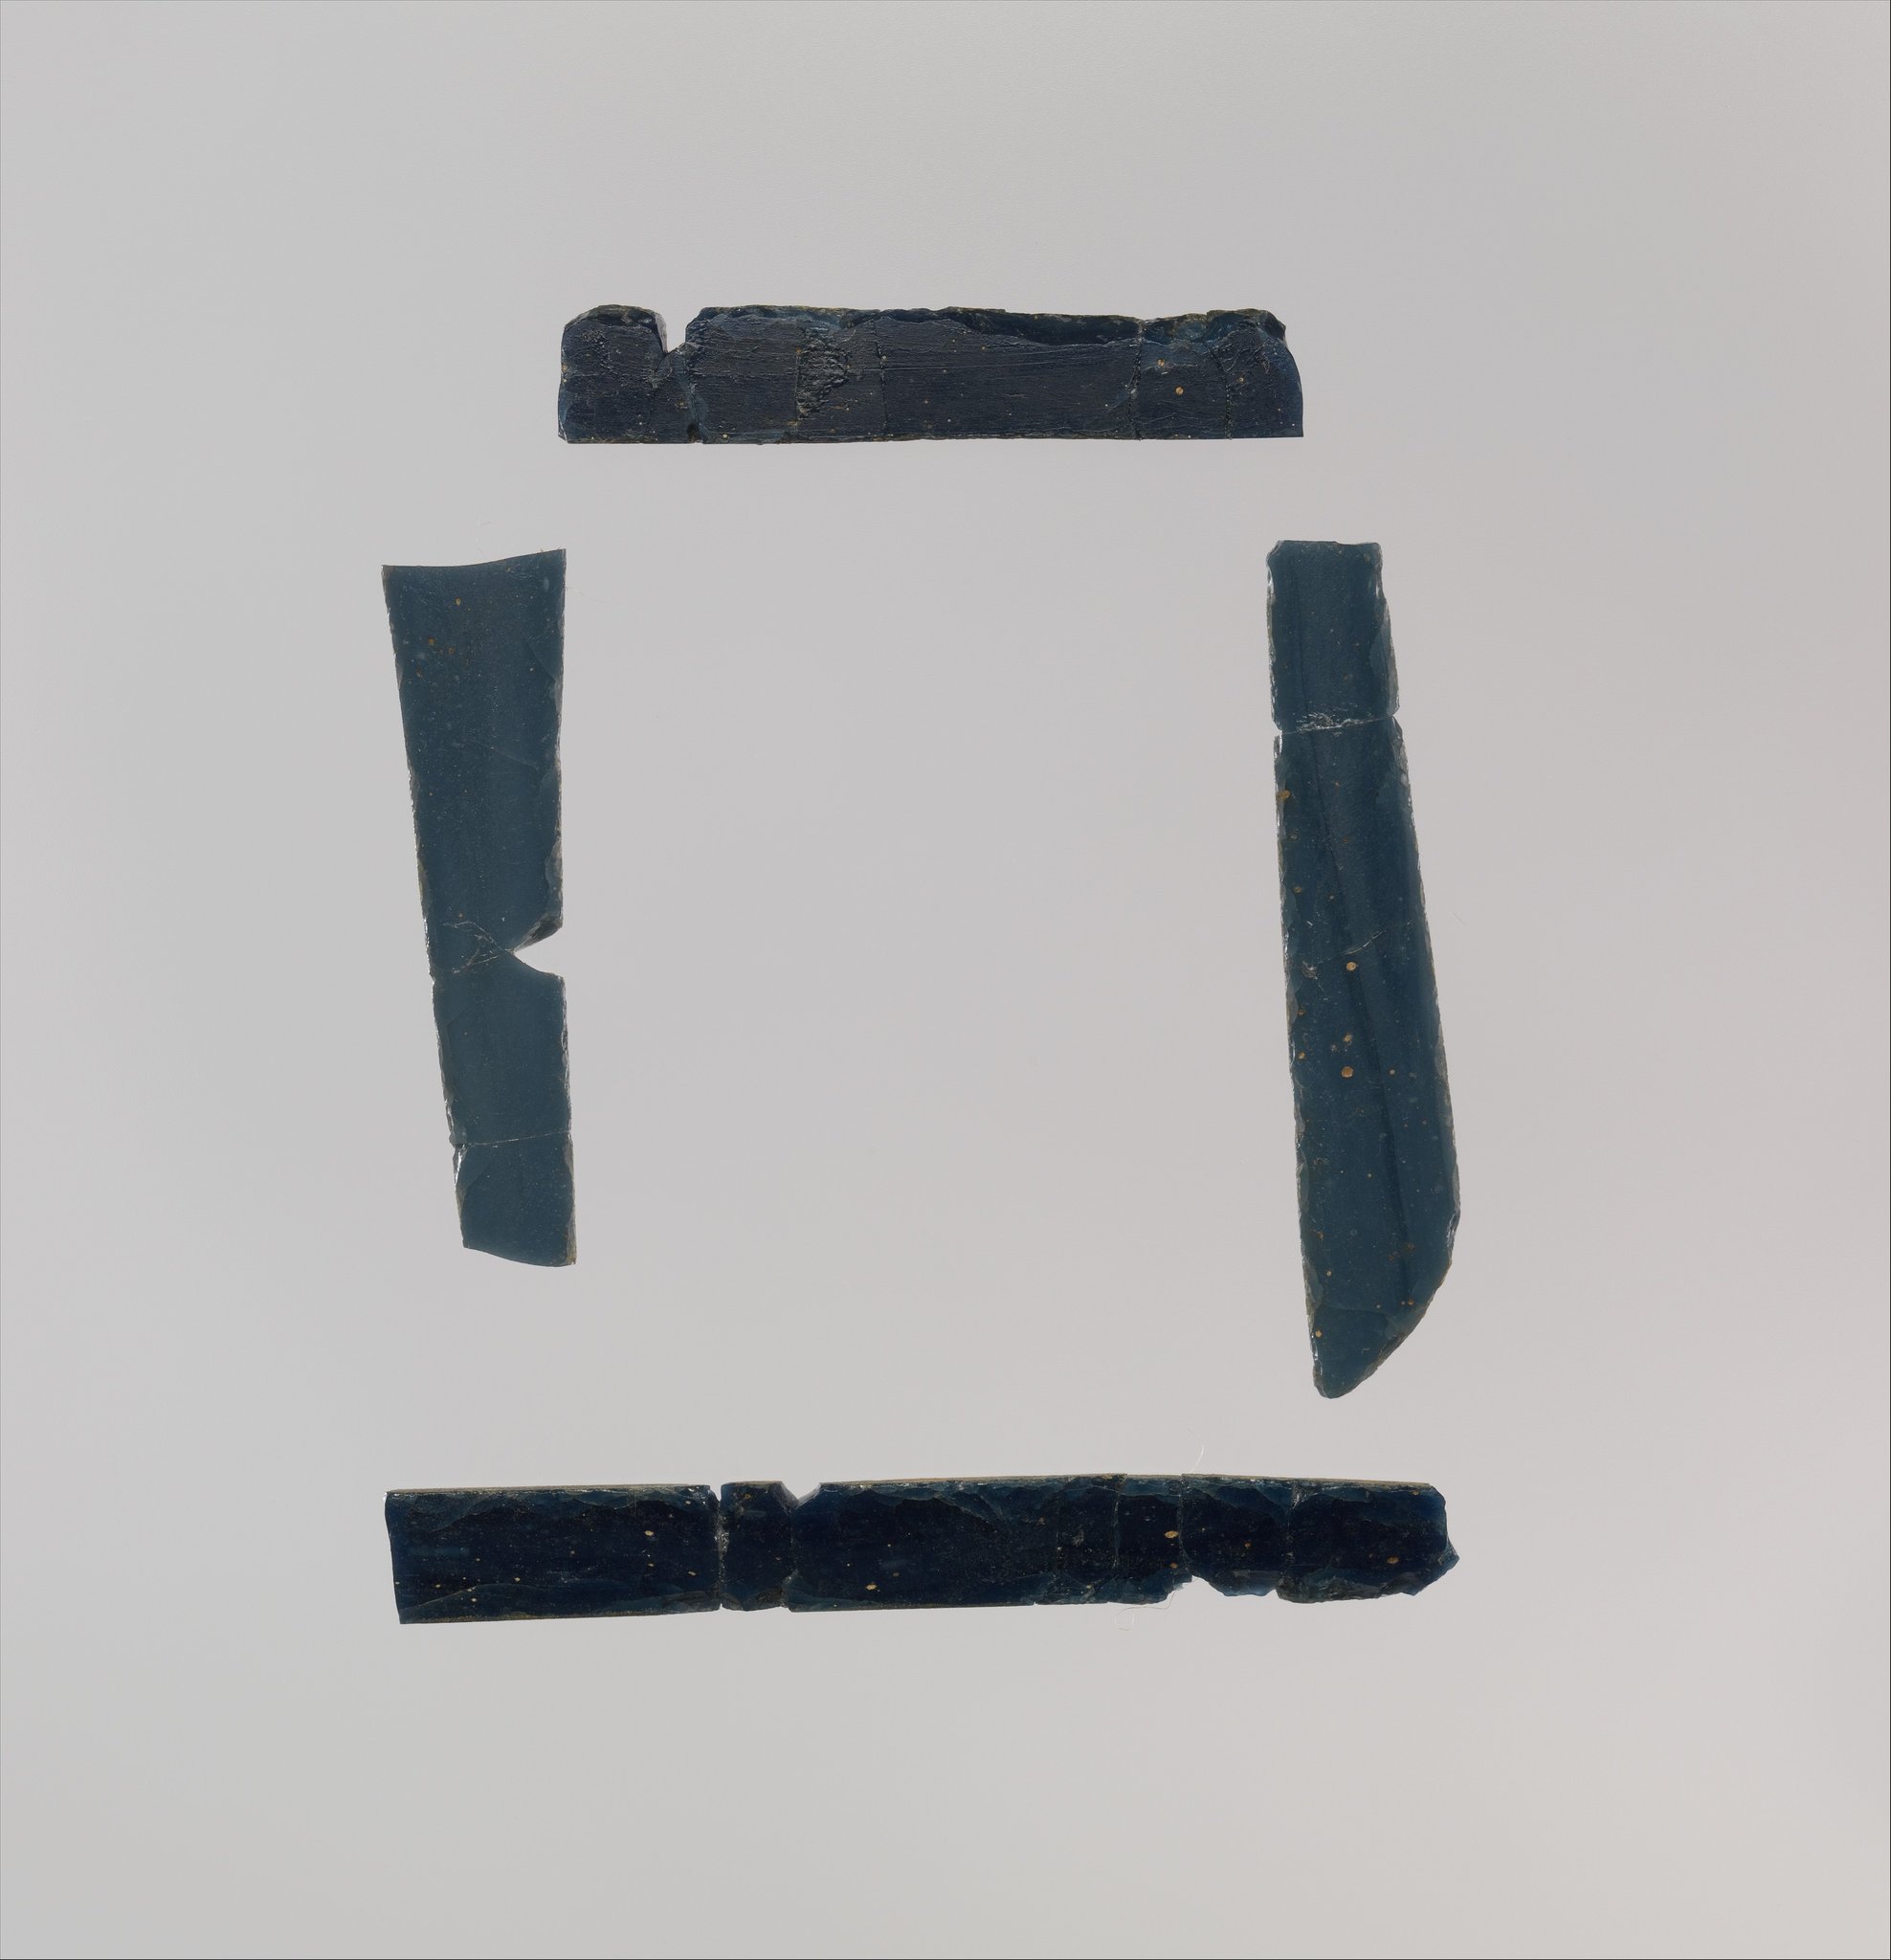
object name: furniture element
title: Furniture elements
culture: assyrian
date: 900-701 BCE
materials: glass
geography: syria